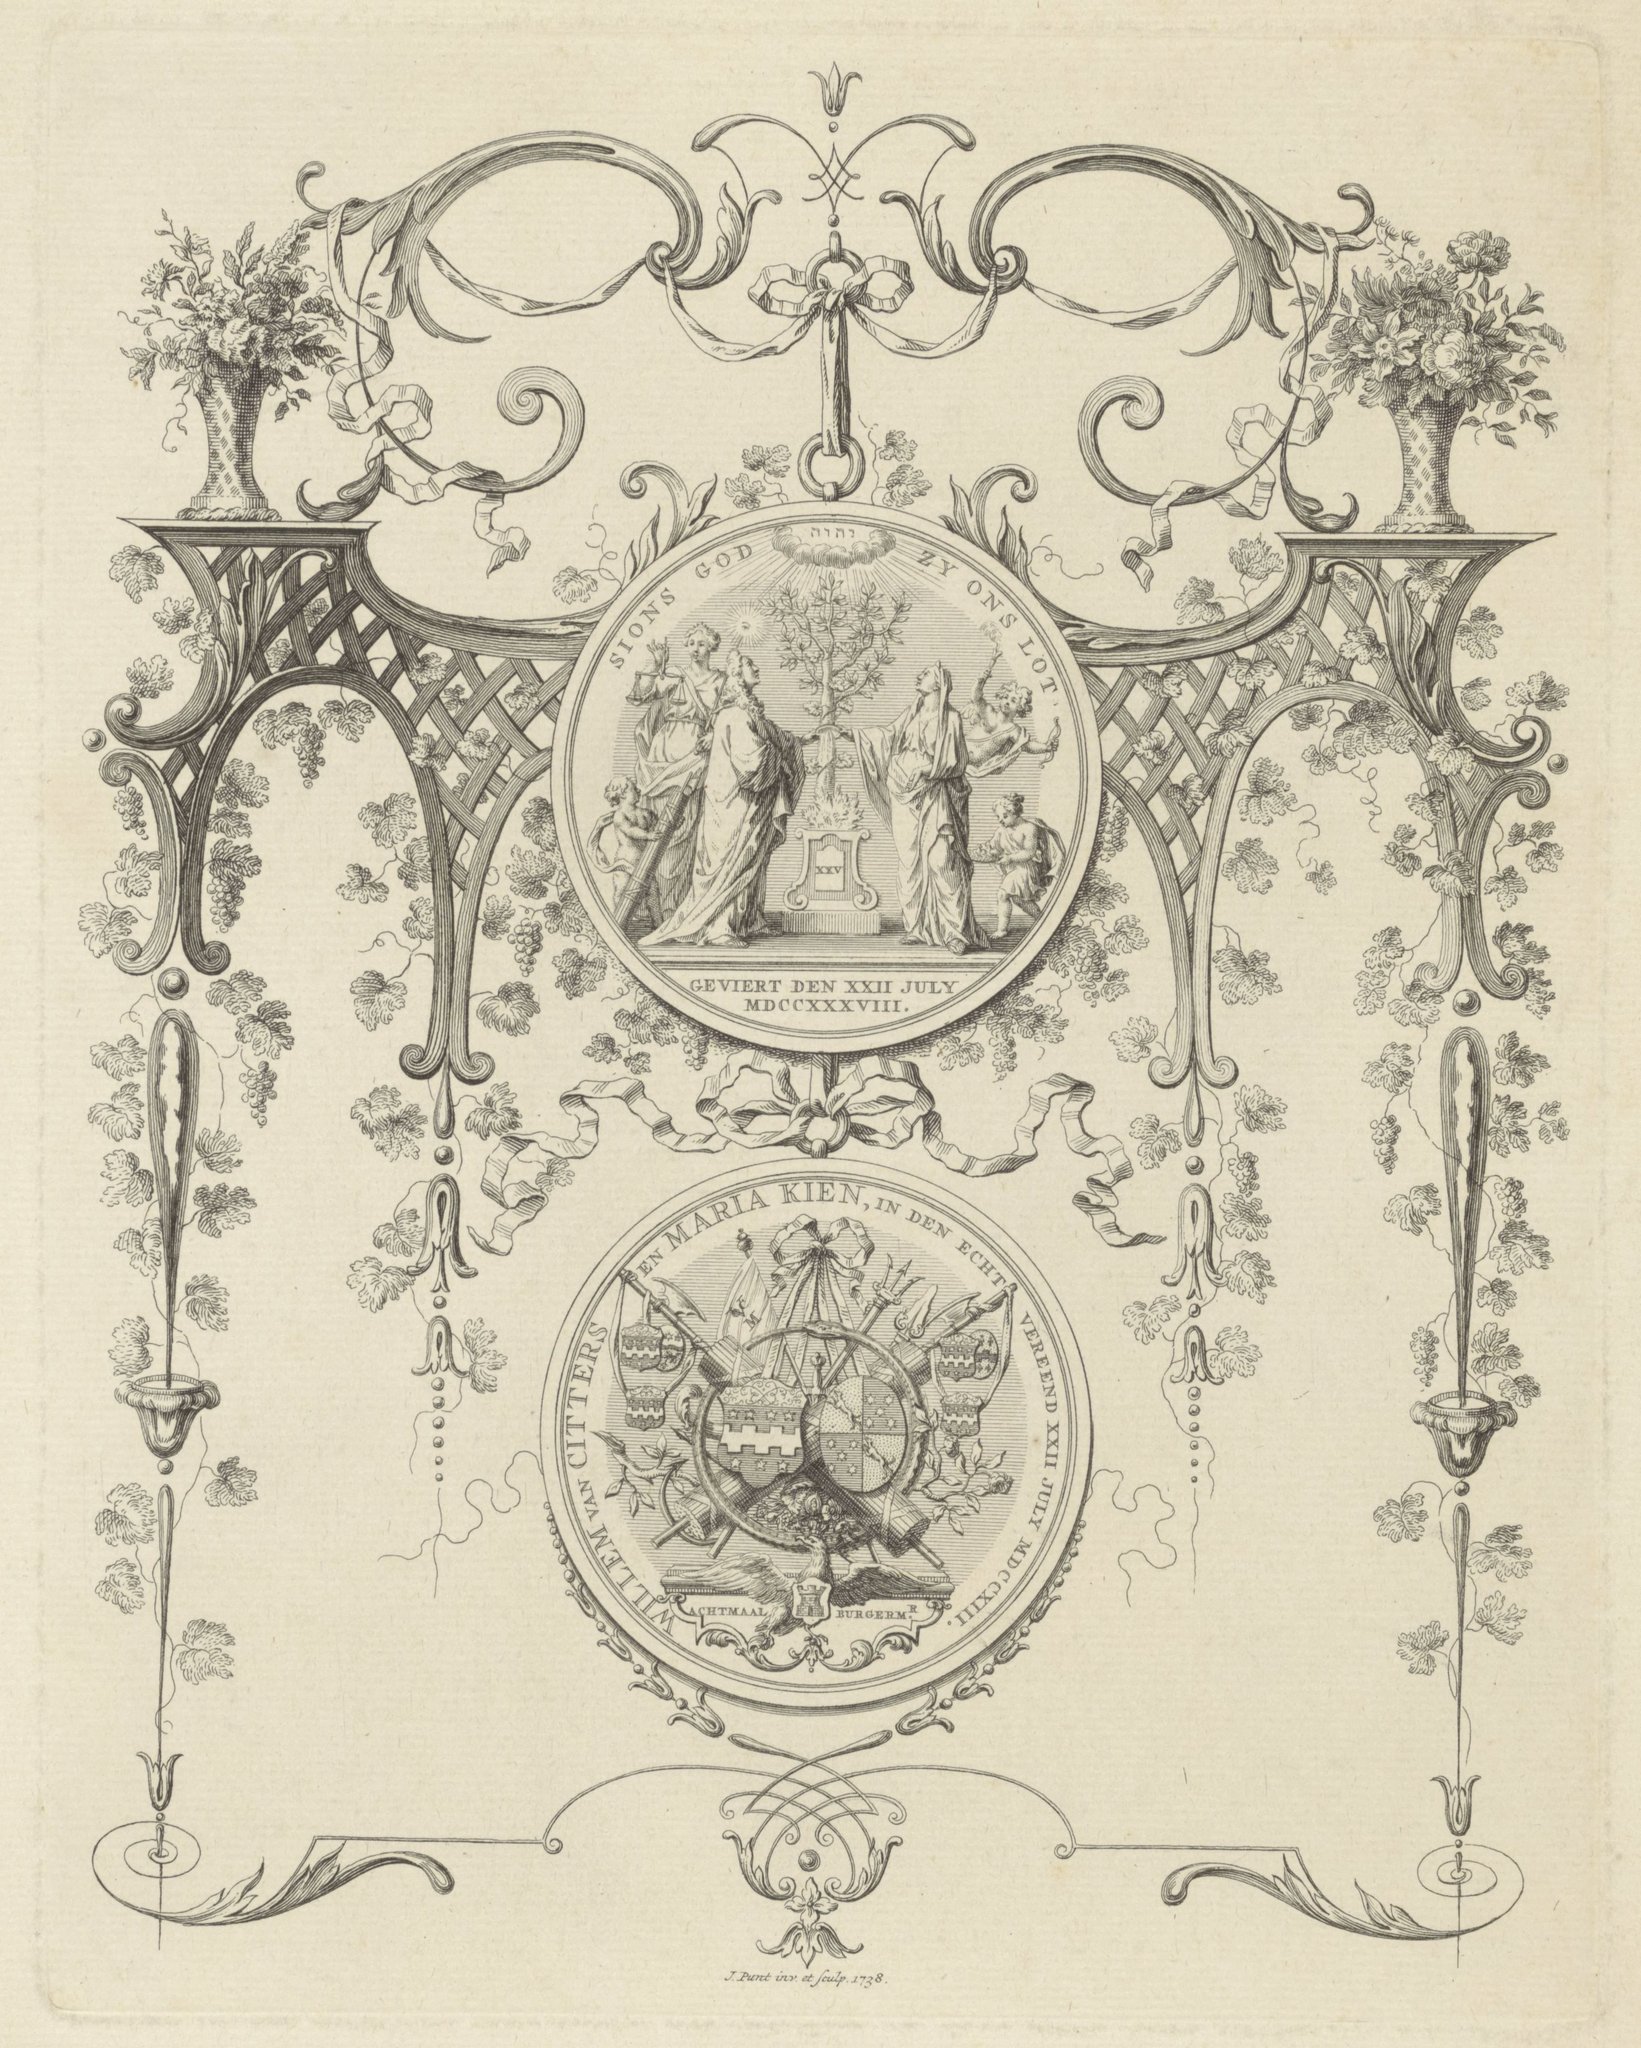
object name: print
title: Penning ter gelegenheid van het zilveren huwelijksjubileum van Willem van Citters en Maria Kien, 1738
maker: jan punt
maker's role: draughtsman, print maker, publisher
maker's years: 1711-1779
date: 1738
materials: paper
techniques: etching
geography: netherlands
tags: london, mayor, silver anniversary, medal (considered as a piece of sculpture, regardless of its specific function)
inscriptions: collector's mark: Lugt 2228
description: Decoratieve voorstelling met de huwelijkspenning bij het vijfentwintigjarig huwelijk in 1738 van Willem van Citters, bewindhebber van de VOC voor de kamer van Zeeland, twaalf maal burgemeester van Middelburg en Maria Kien, gehuwd op 22 juli 1713.